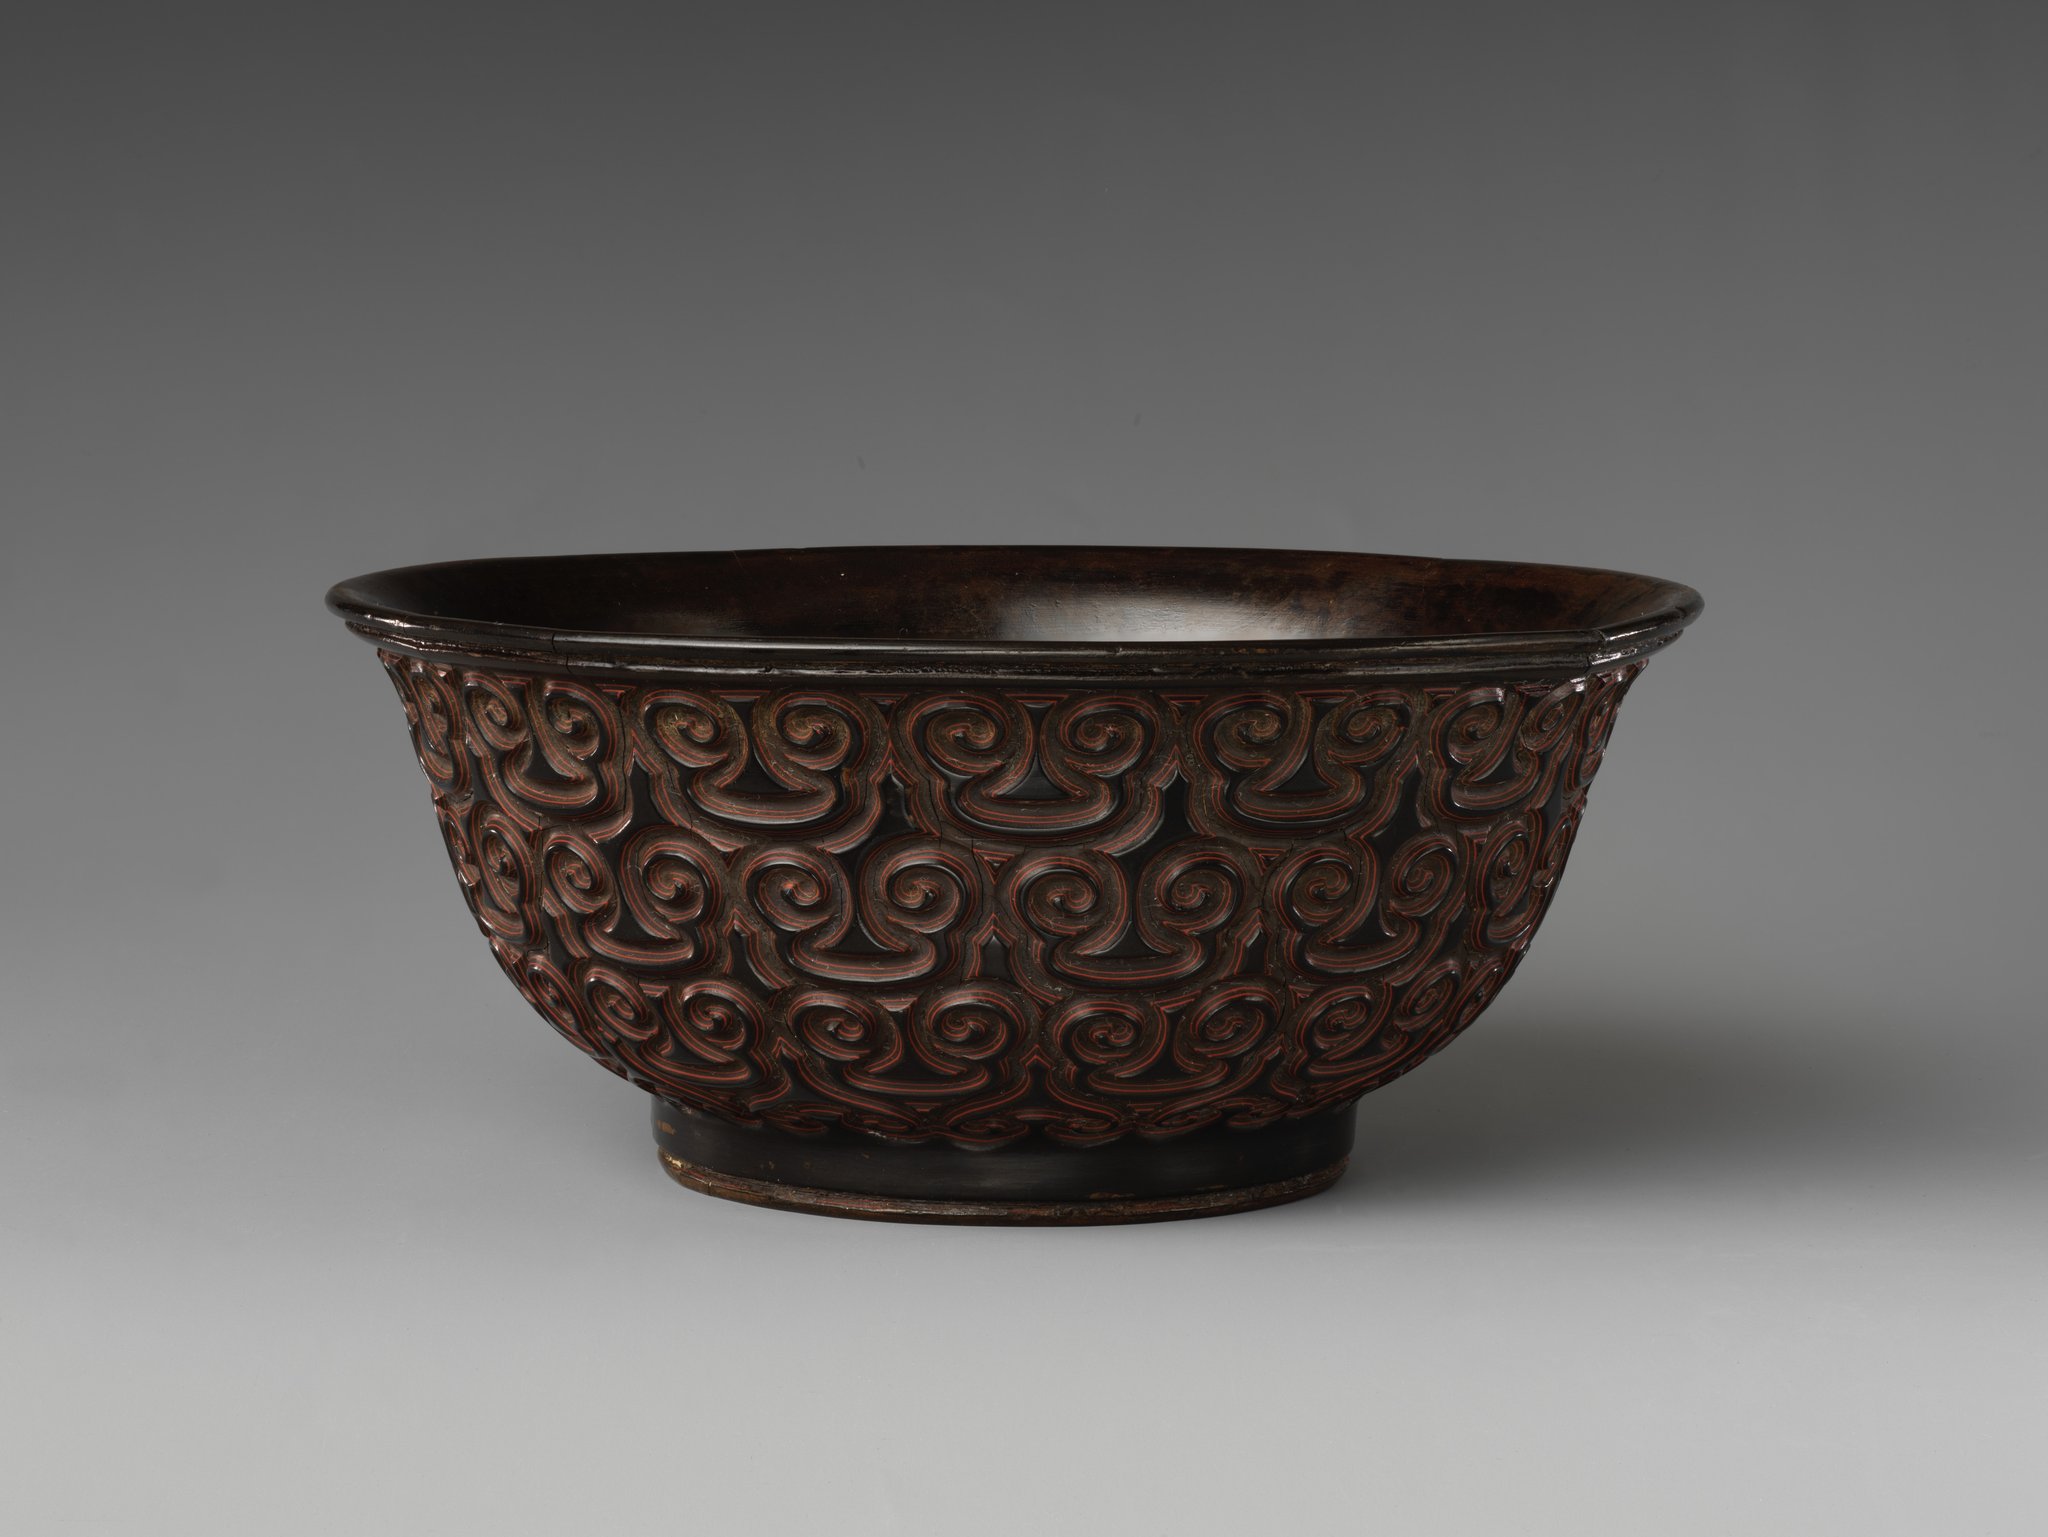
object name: bowl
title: Guri bowl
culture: chinese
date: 1368-1644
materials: lacquer